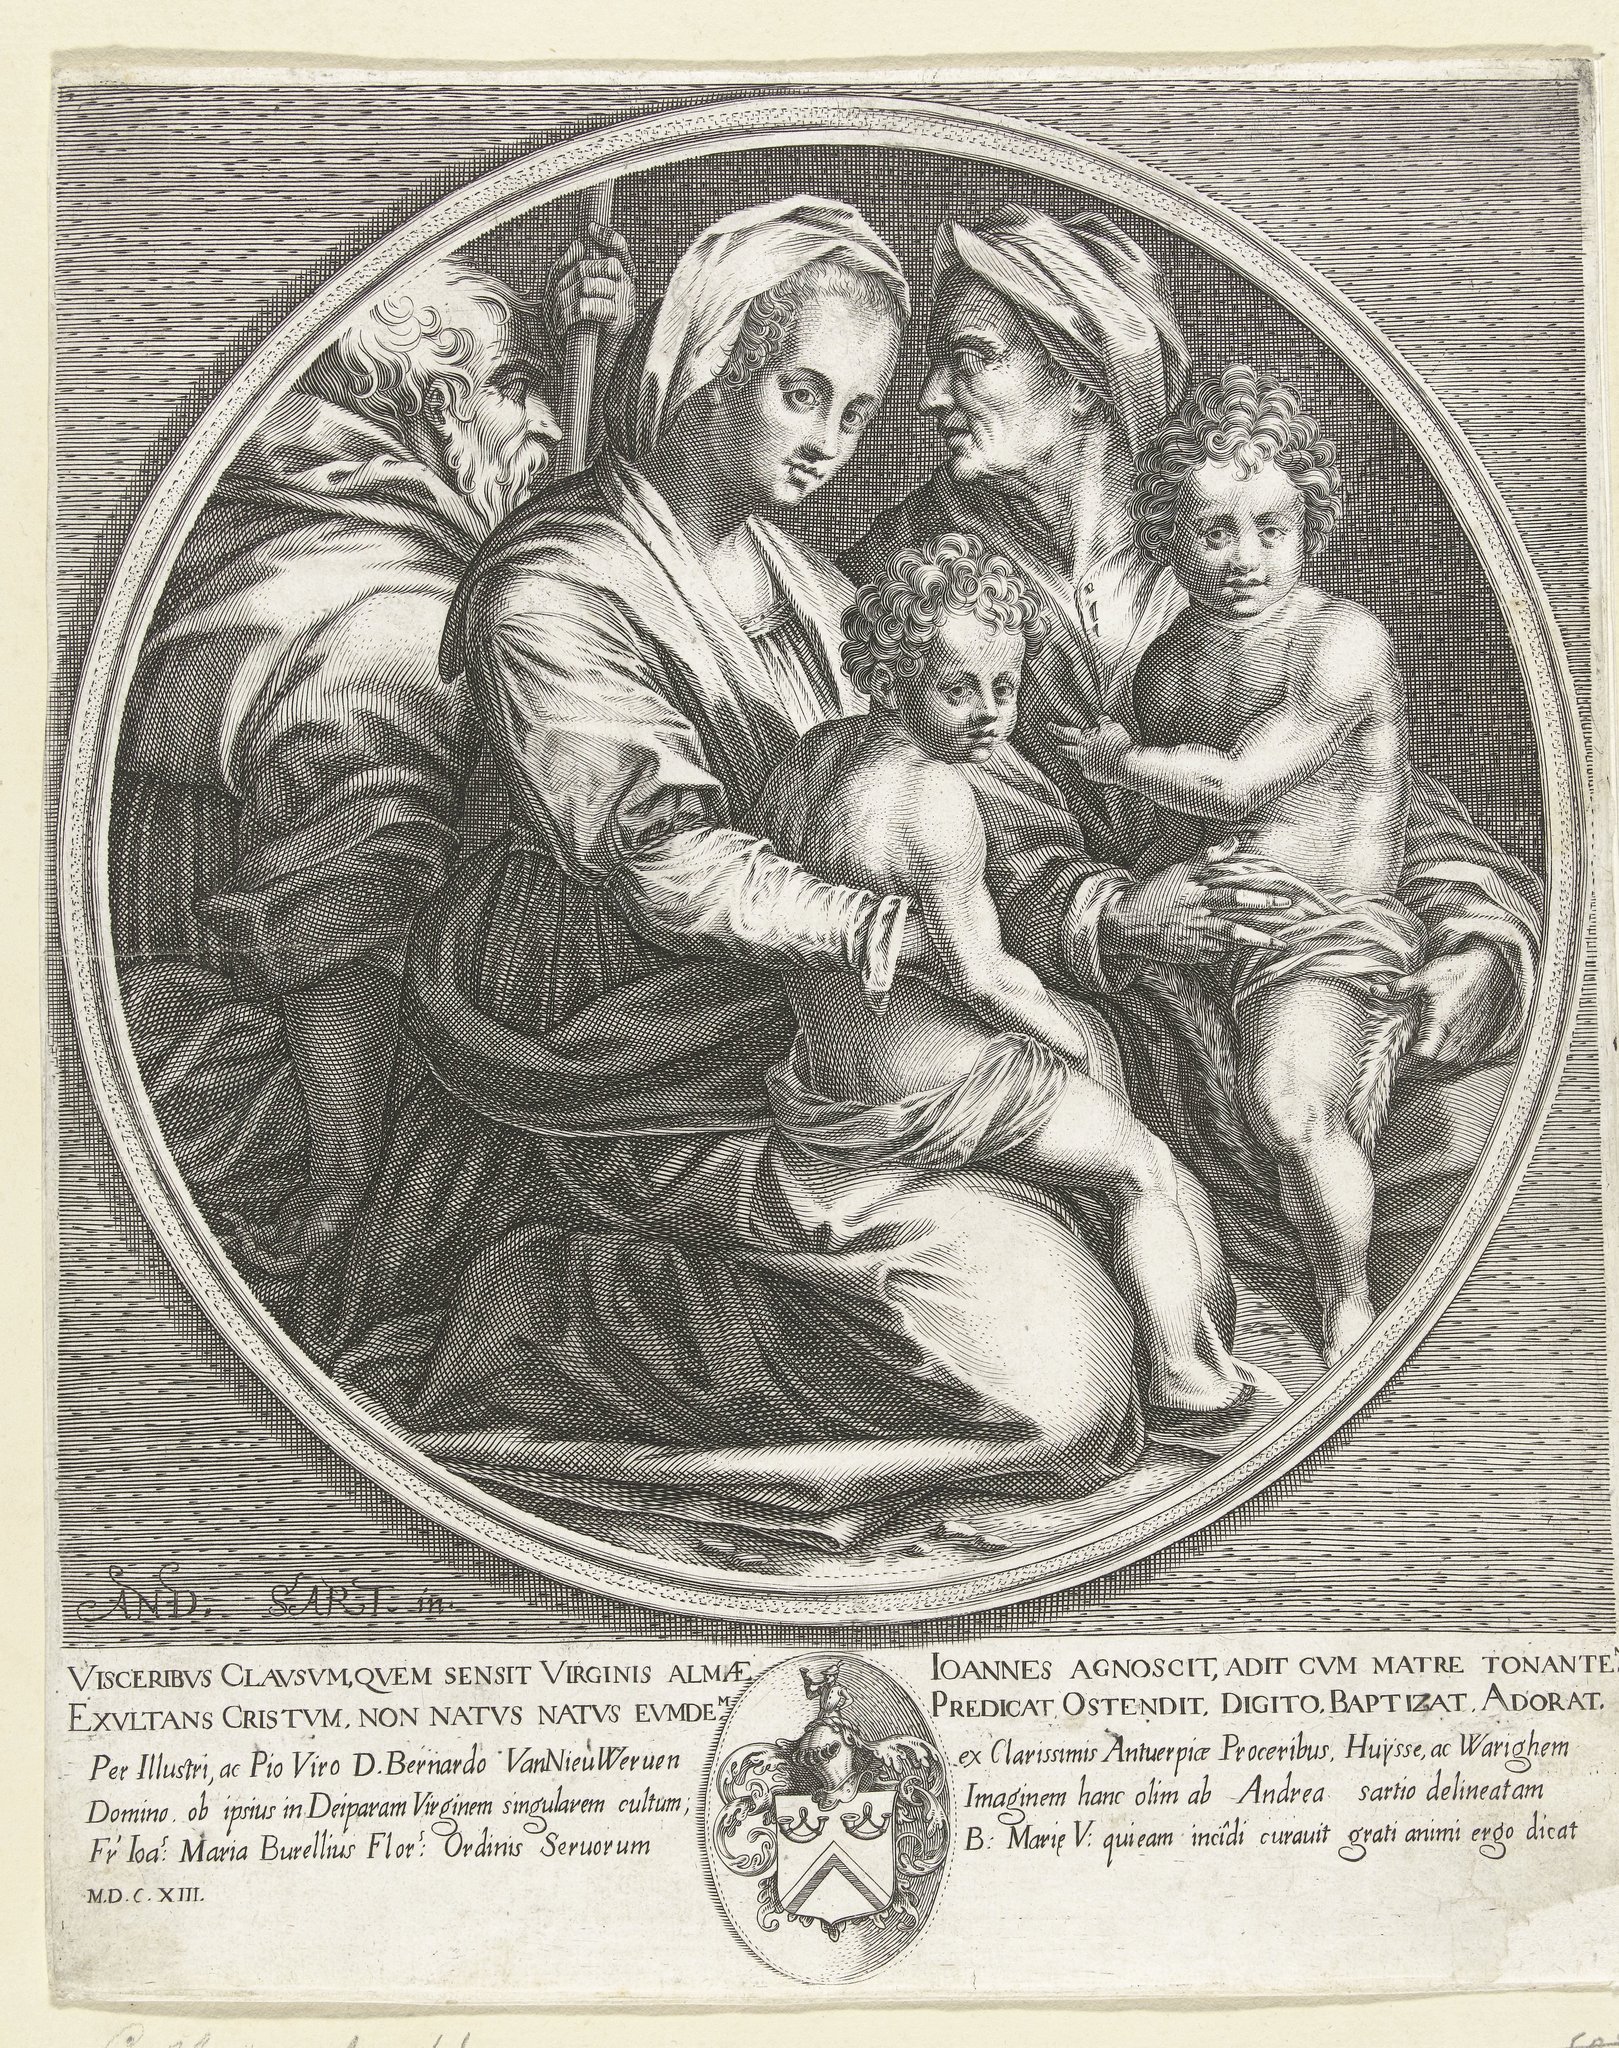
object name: print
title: Heilige Familie met Elizabeth en Johannes de Doper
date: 1613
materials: paper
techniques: engraving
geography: florence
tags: holy family with john the baptist, elisabeth present, armorial bearing, heraldry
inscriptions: collector's mark: Lugt 240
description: Maria met het Christuskind op schoot, naast Elizabeth met het kind Johannes de Doper. Achter Maria, links, Jozef met een stok of staf in de hand. Dit familieportret is gevat in een ronde omlijsting op een vierkante, gearceerde achtergrond. Onder de voorstelling een Latijns onderschrift en een familiewapen omgeven door bladmotieven en bekroond door een helm.